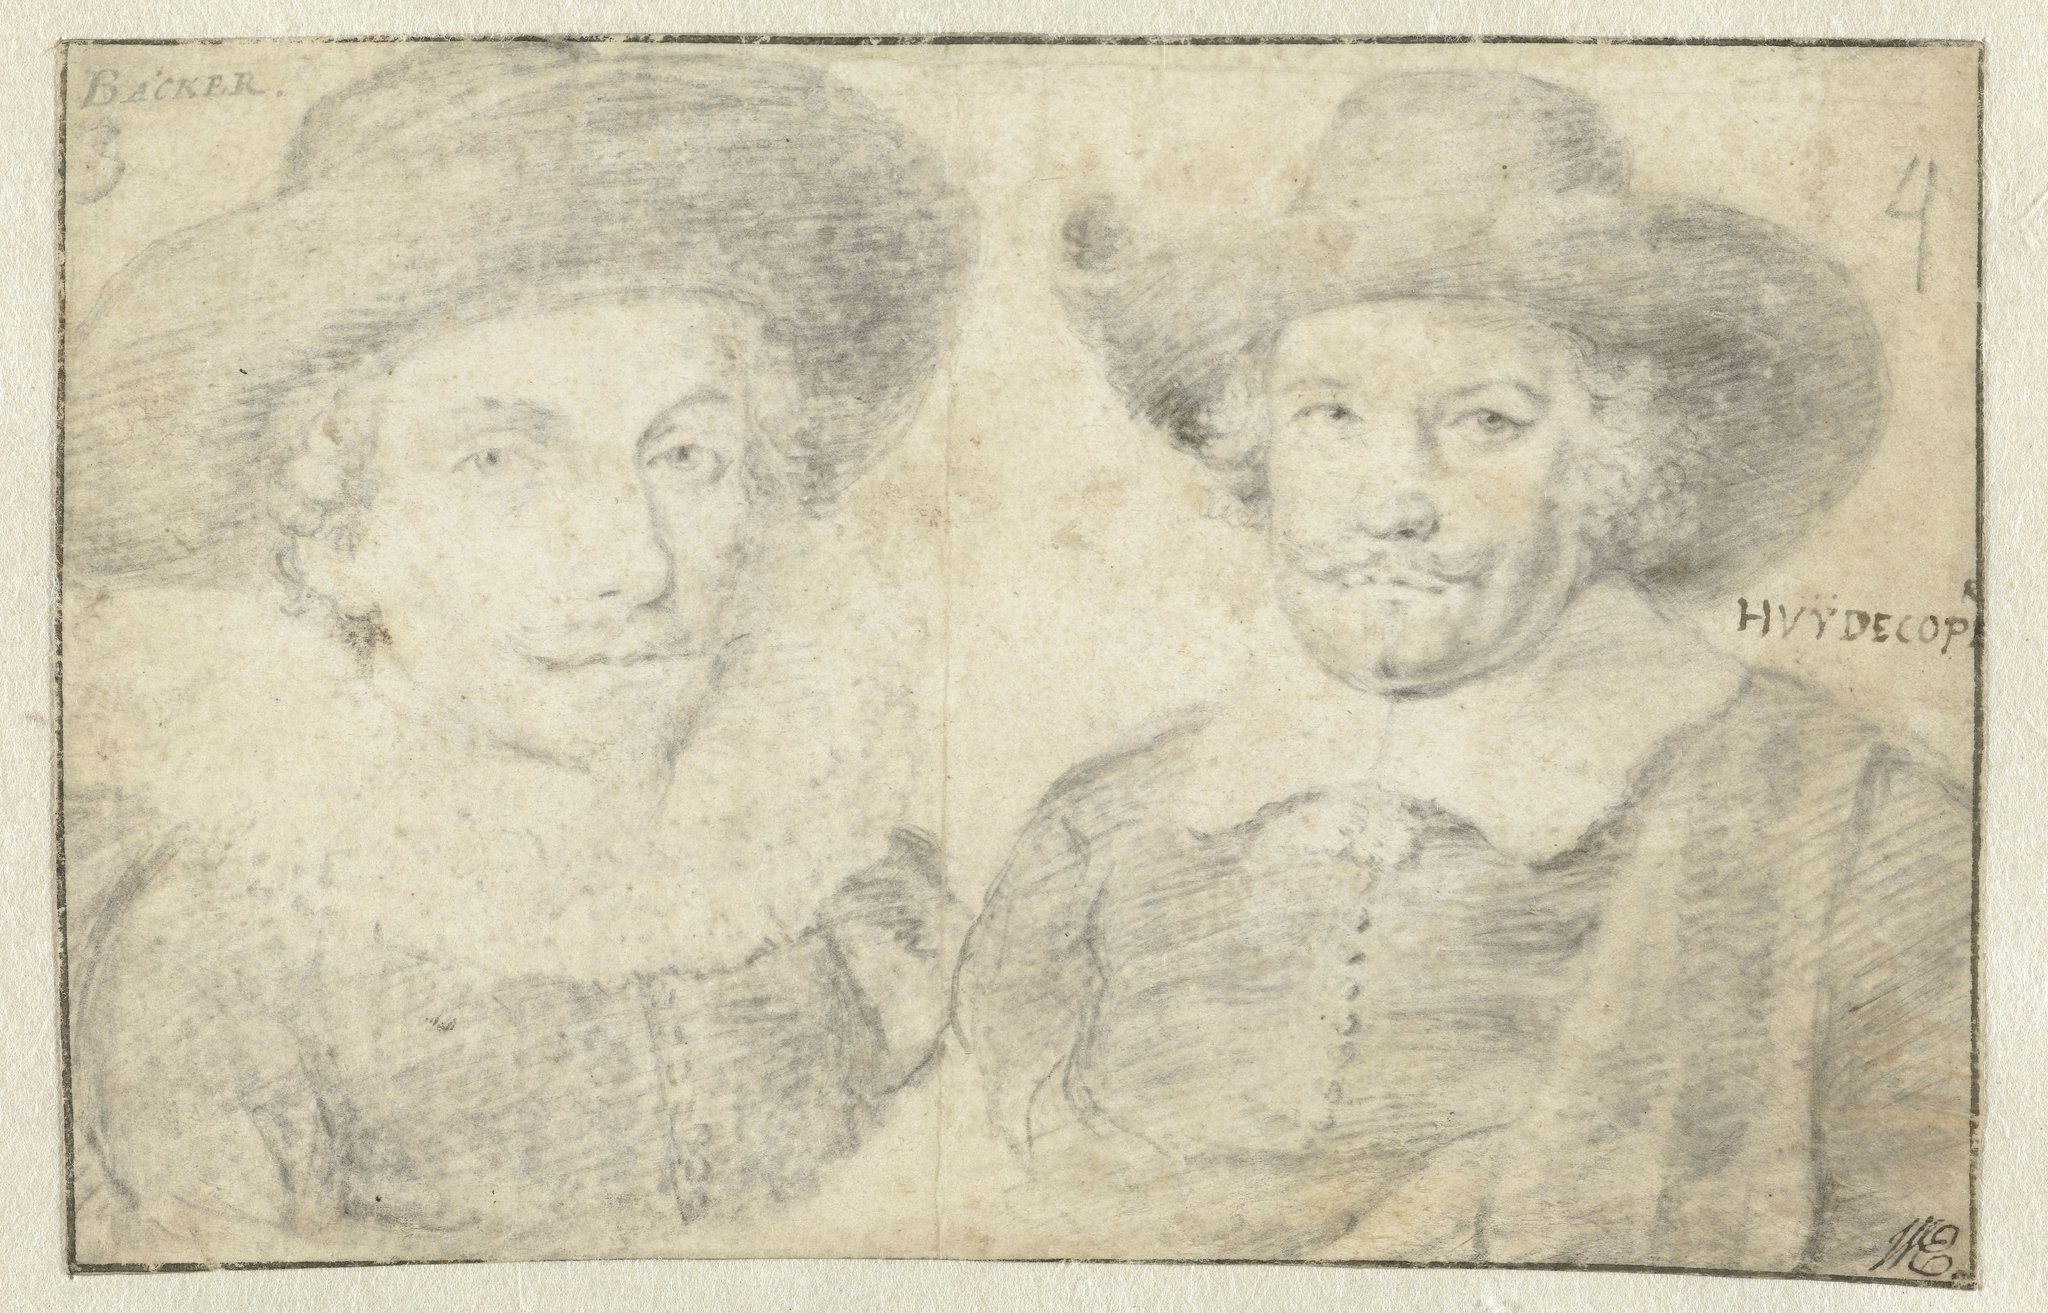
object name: drawing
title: Portretten van Joris Backer en Jan Huydecoper van Maarseveen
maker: Anonymous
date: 1642-1700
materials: parchment, pencil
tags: amsterdam, mayor, joan huydecoper van maarseveen (i)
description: Pendant van 'Portretten van Cornelis de Graeff en Frans Banningh Cocq', inventarisnummer RP-T-00-14.